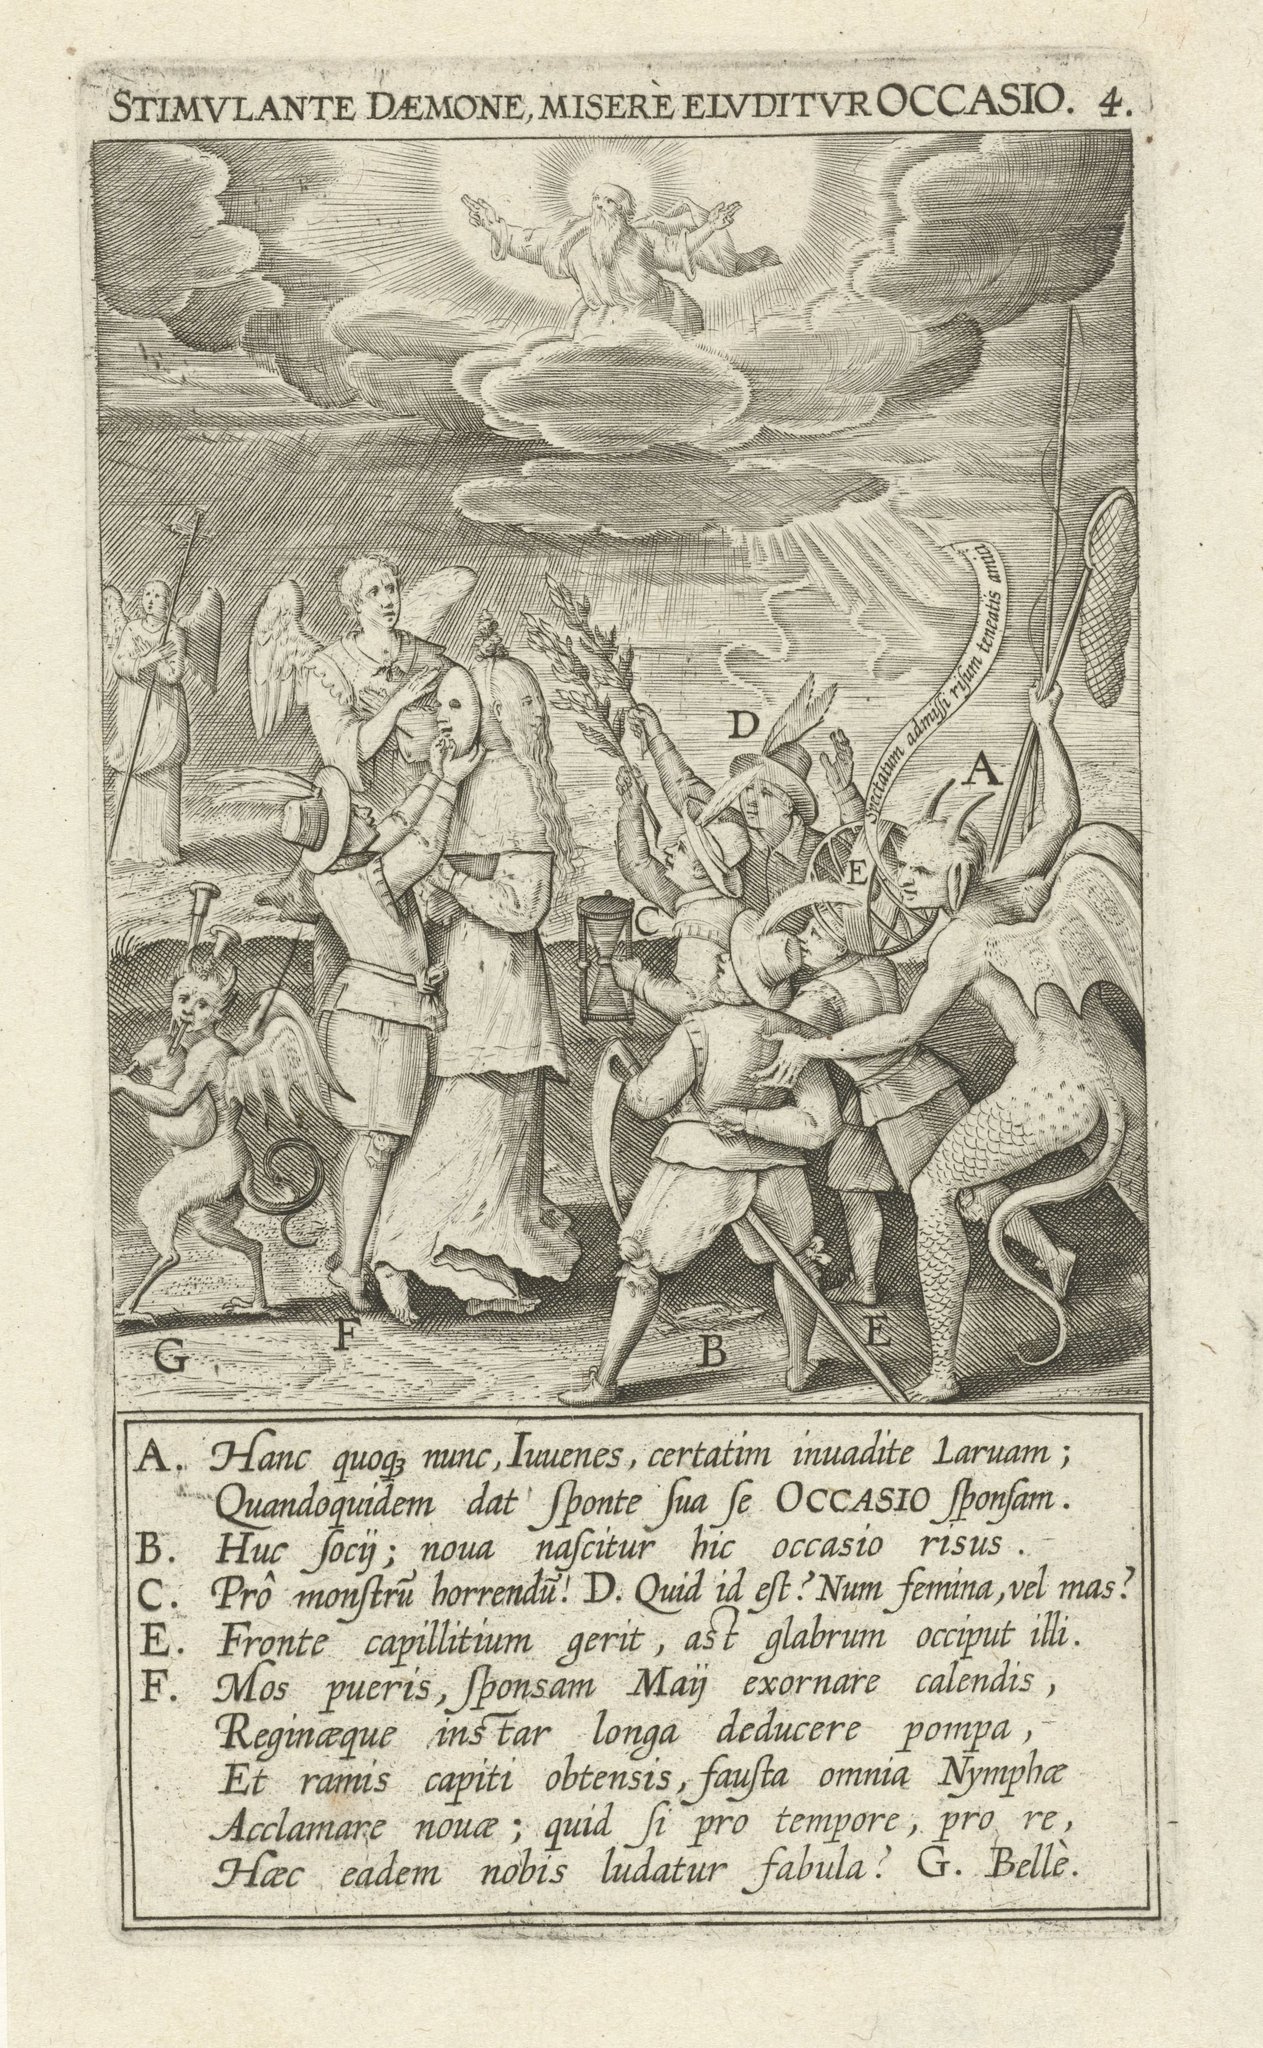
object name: print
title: Zondige jongeren verspelen de kansen die het leven biedt door spel en plezier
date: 1603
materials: paper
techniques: engraving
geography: antwerp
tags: 'occasio', 'kairos'; 'occasione' (ripa), face, children's games and plays, god the father, youth, adolescent, devil(s) appearing to mortals, trying to seduce them; temptation, other allegories of time, e.g. 'tempo' (ripa), angels, man as sinner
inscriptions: collector's mark: Lugt 2228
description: Zondige jongeren spelen, samen met duivels, met de attributen van de personificatie Kans (Occasio). Een van de jongeren zet Kans een masker op. Op de achtergrond de engel van het Geloof. Bovenaan kijkt God toe. De prent heeft een Latijns onderschrift met legende en maakt deel uit van een 12-delige serie over het benutten van kansen.